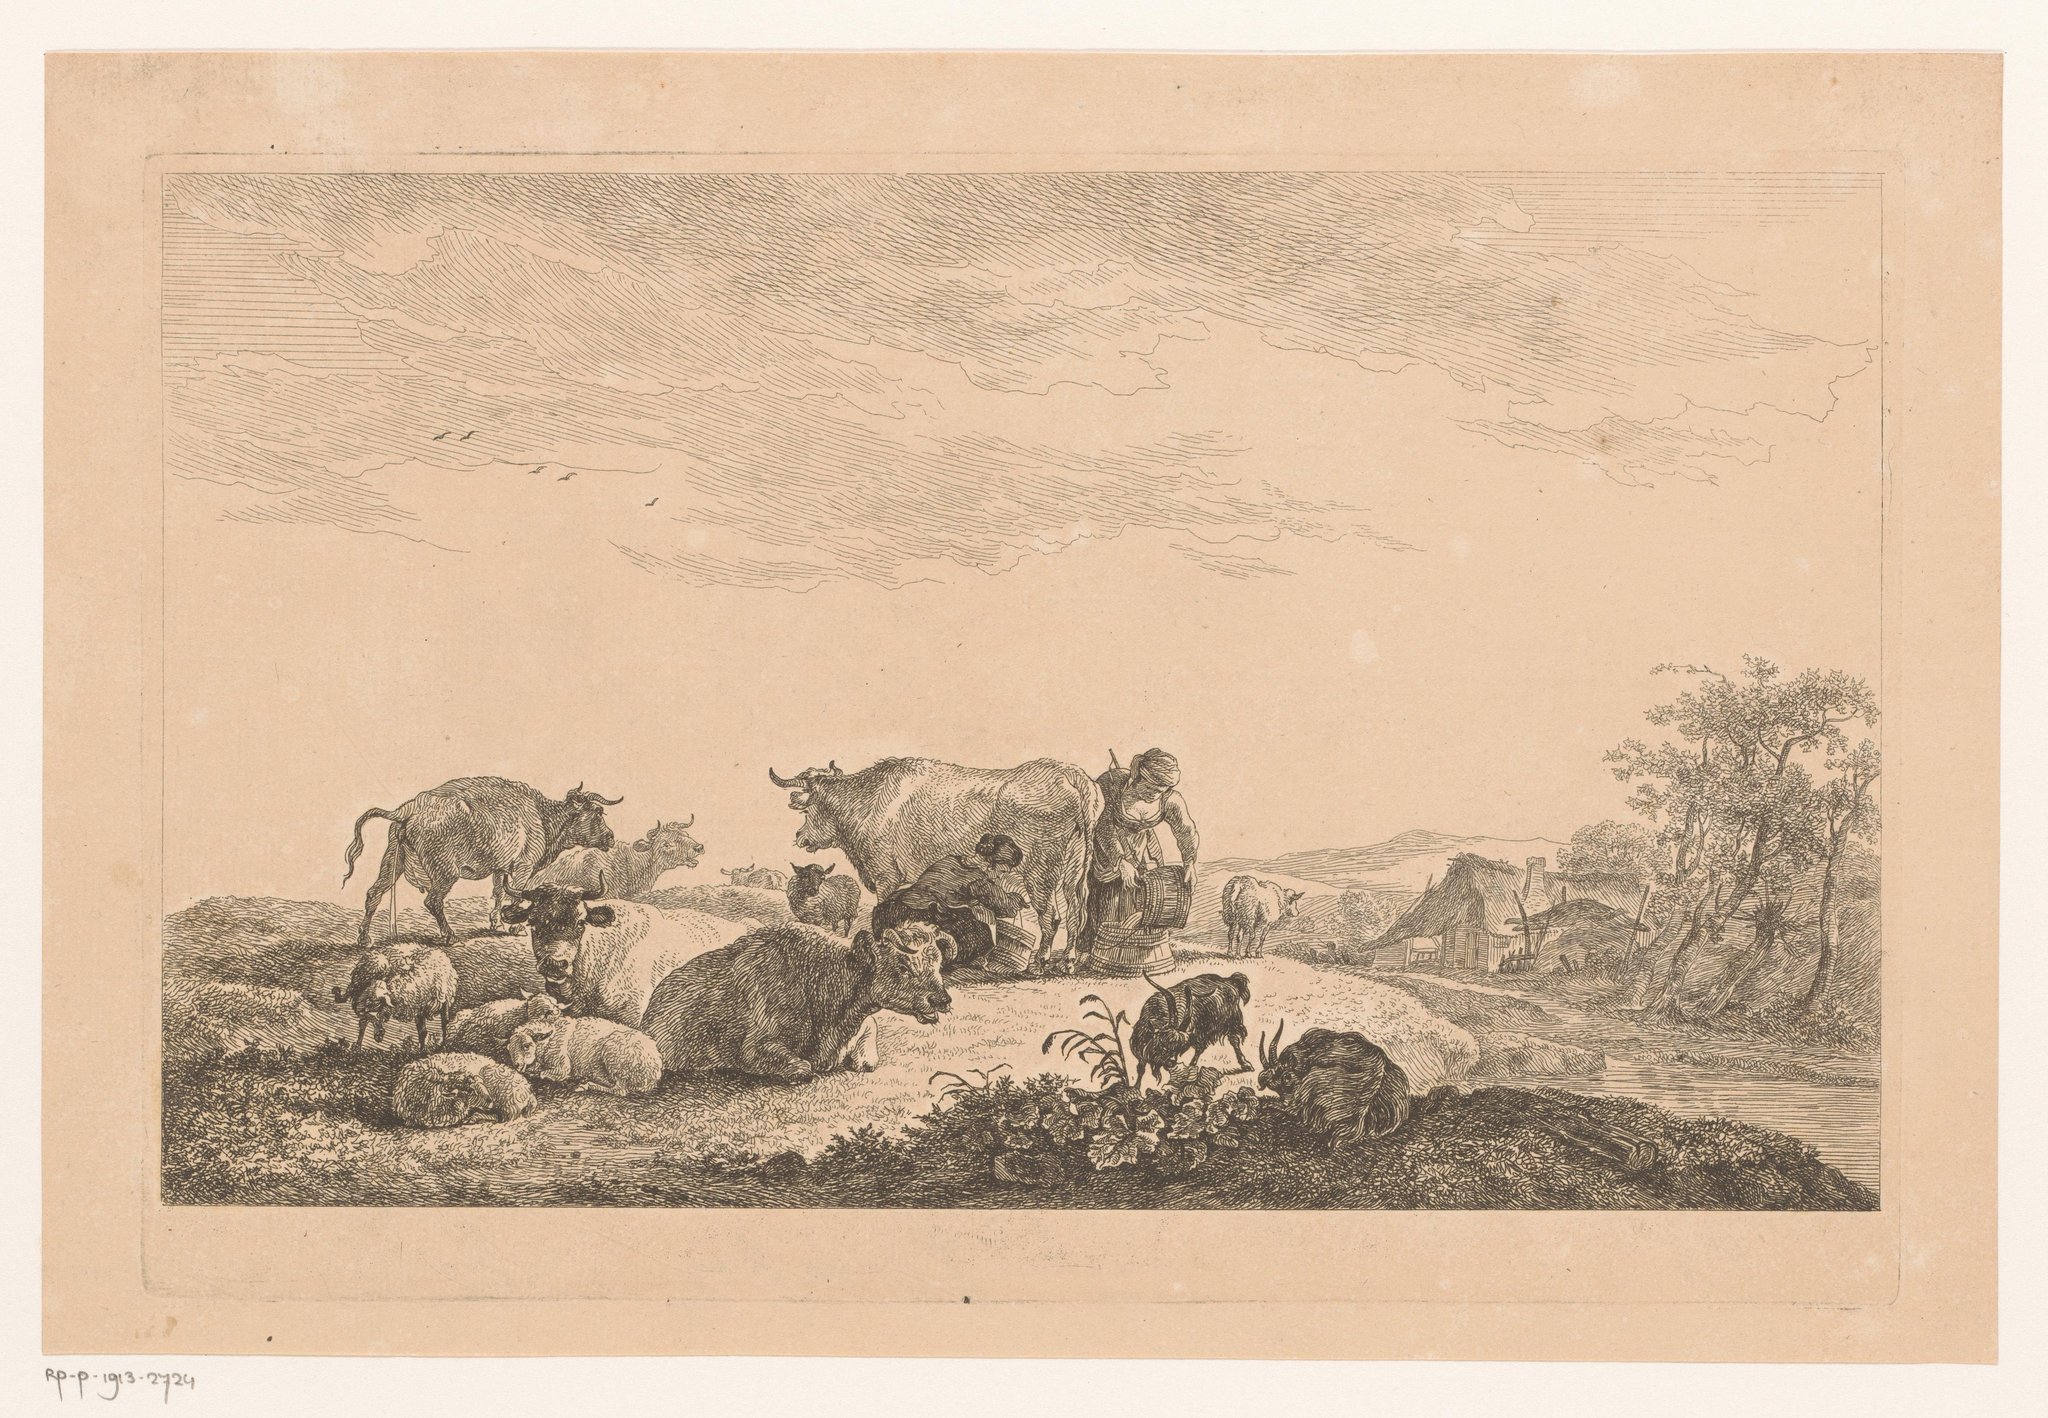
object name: print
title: Twee boerinnen melken koeien in de wei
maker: jean baptiste de roy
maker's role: print maker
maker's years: 1759-1839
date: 1769-1839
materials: paper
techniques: etching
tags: cow, milking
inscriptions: collector's mark: Lugt 2228, collector's mark: Lugt 1485